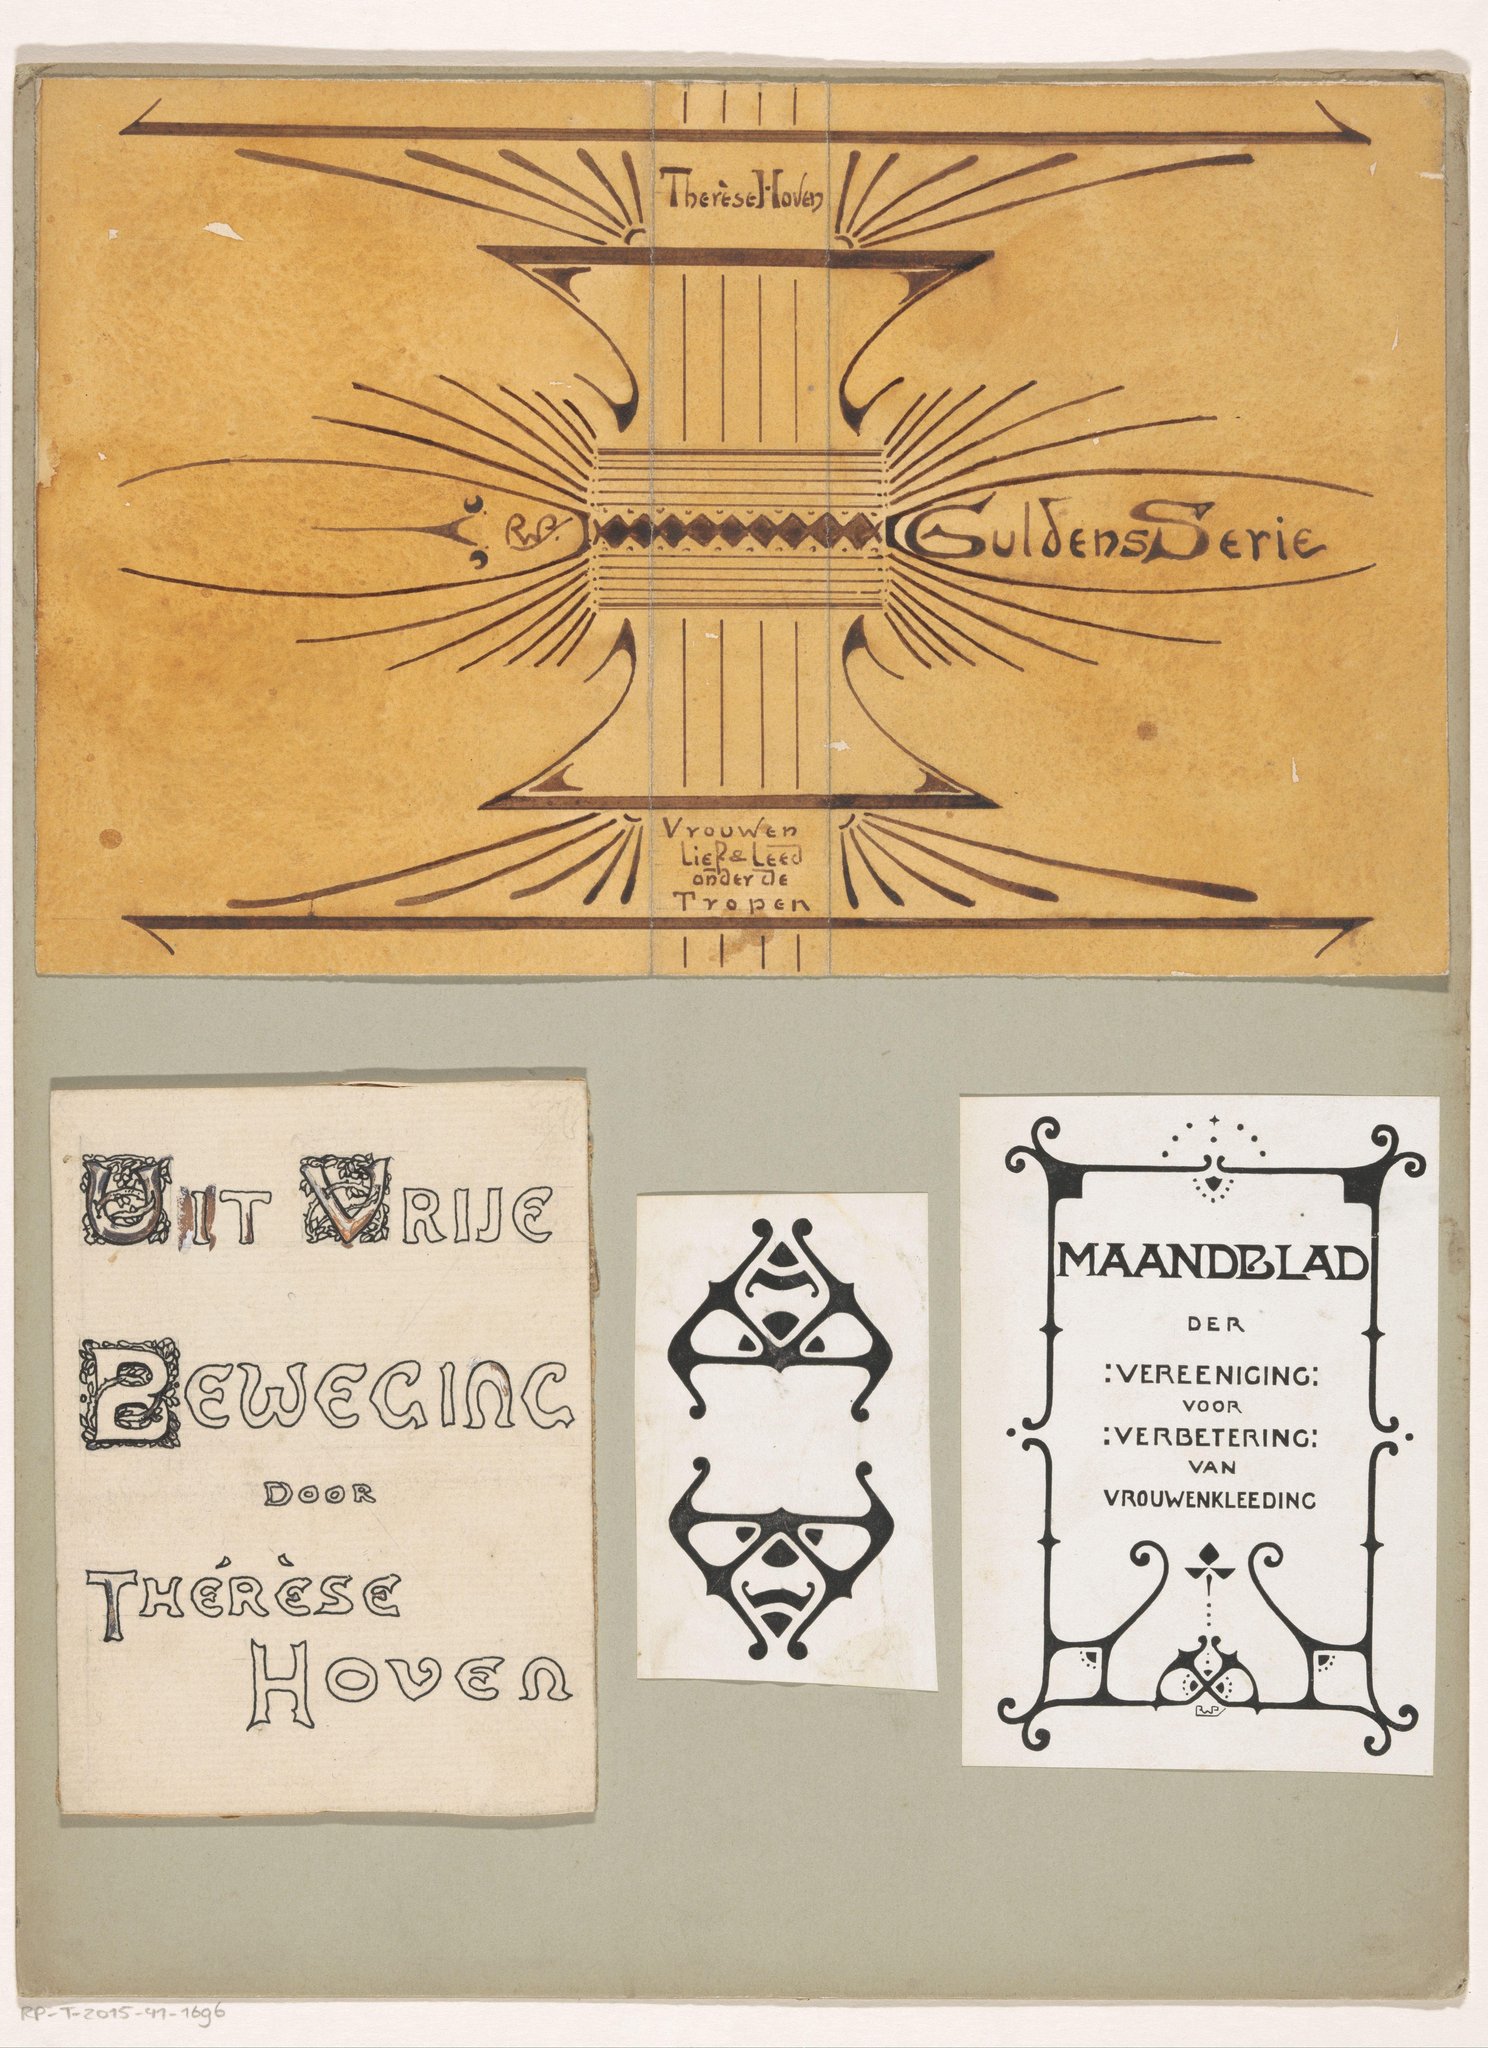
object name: drawing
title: Bandontwerpen voor: Thérèse Hoven, Vrouwen lief en leed onder de tropen (1896) en Uit vrije beweging (1894)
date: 1894-1909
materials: cardboard, paint, ink, paper, pencil, watercolor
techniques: brush, pen, printing block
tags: ornament ~ combination of straight and curved lines, foliage, tendrils, branches ~ ornament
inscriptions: collector's mark: Lugt 2228, monogram: ‘RWPV’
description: Ontwerp voor 'Vrouwen lief en leed onder de tropen' met over het voor- en achterplat doorlopende symmetrische lijnen. Ontwerp voor 'Uit vrije beweging' met versierde initialen met bladornamenten. Tevens een ontwerp voor het Maandblad der vereeniging voor verbetering van vrouwenkleding en een ornament.